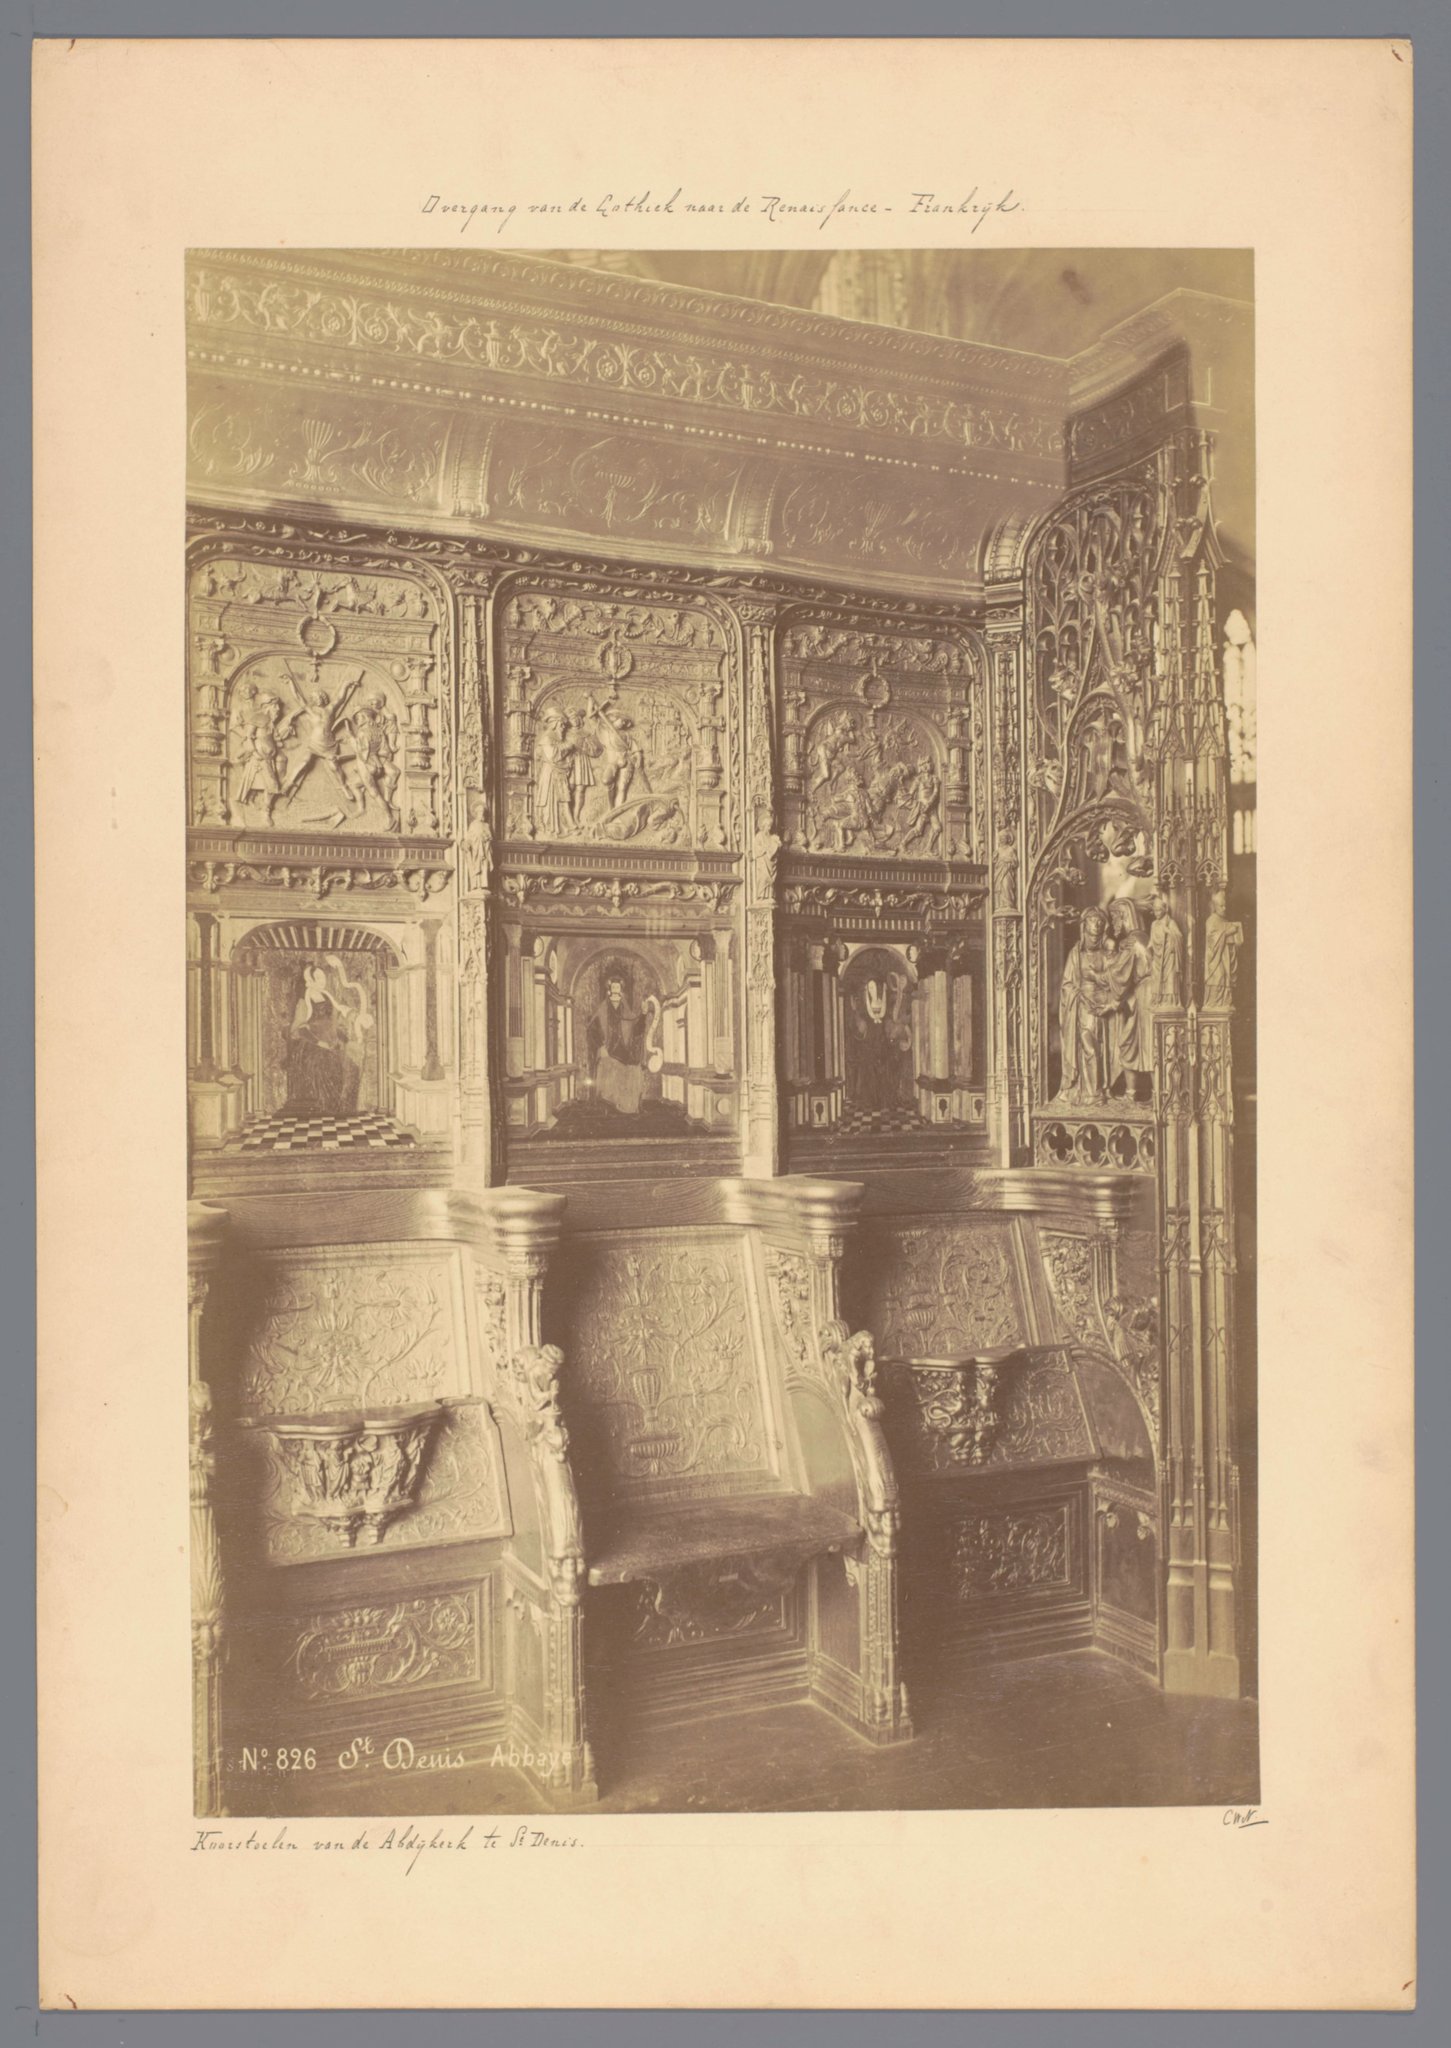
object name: photograph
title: St. Denis Abbaye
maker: séraphin-médéric mieusement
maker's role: fotograaf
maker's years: 1840-1905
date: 1875-1900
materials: cardboard, photographic support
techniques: albumen print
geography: saint-denis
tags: seats of the clergy, choir-stalls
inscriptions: collector's mark: ‘KUNSTNIJVERHEIDSCHOOL QUELLINUS AMSTERDAM FRANS HALSSTRAAT 14.’, inscription: ‘CWN.’, collector's mark: ‘INSTITUUT VOOR KUNST-NIJVERHEIDSONDERWIJS GABRIËL METSUSTRAAT No. 16 AMSTERDAM’, inscription: ‘Ovegang van Gothiek naar de Renaissance - Frankrijk.’, number: ‘No. 826’, name: ‘IEUSEMENT PHOTOGRAPHE’, inscription: ‘MONUMENTS HISTORIQUES’